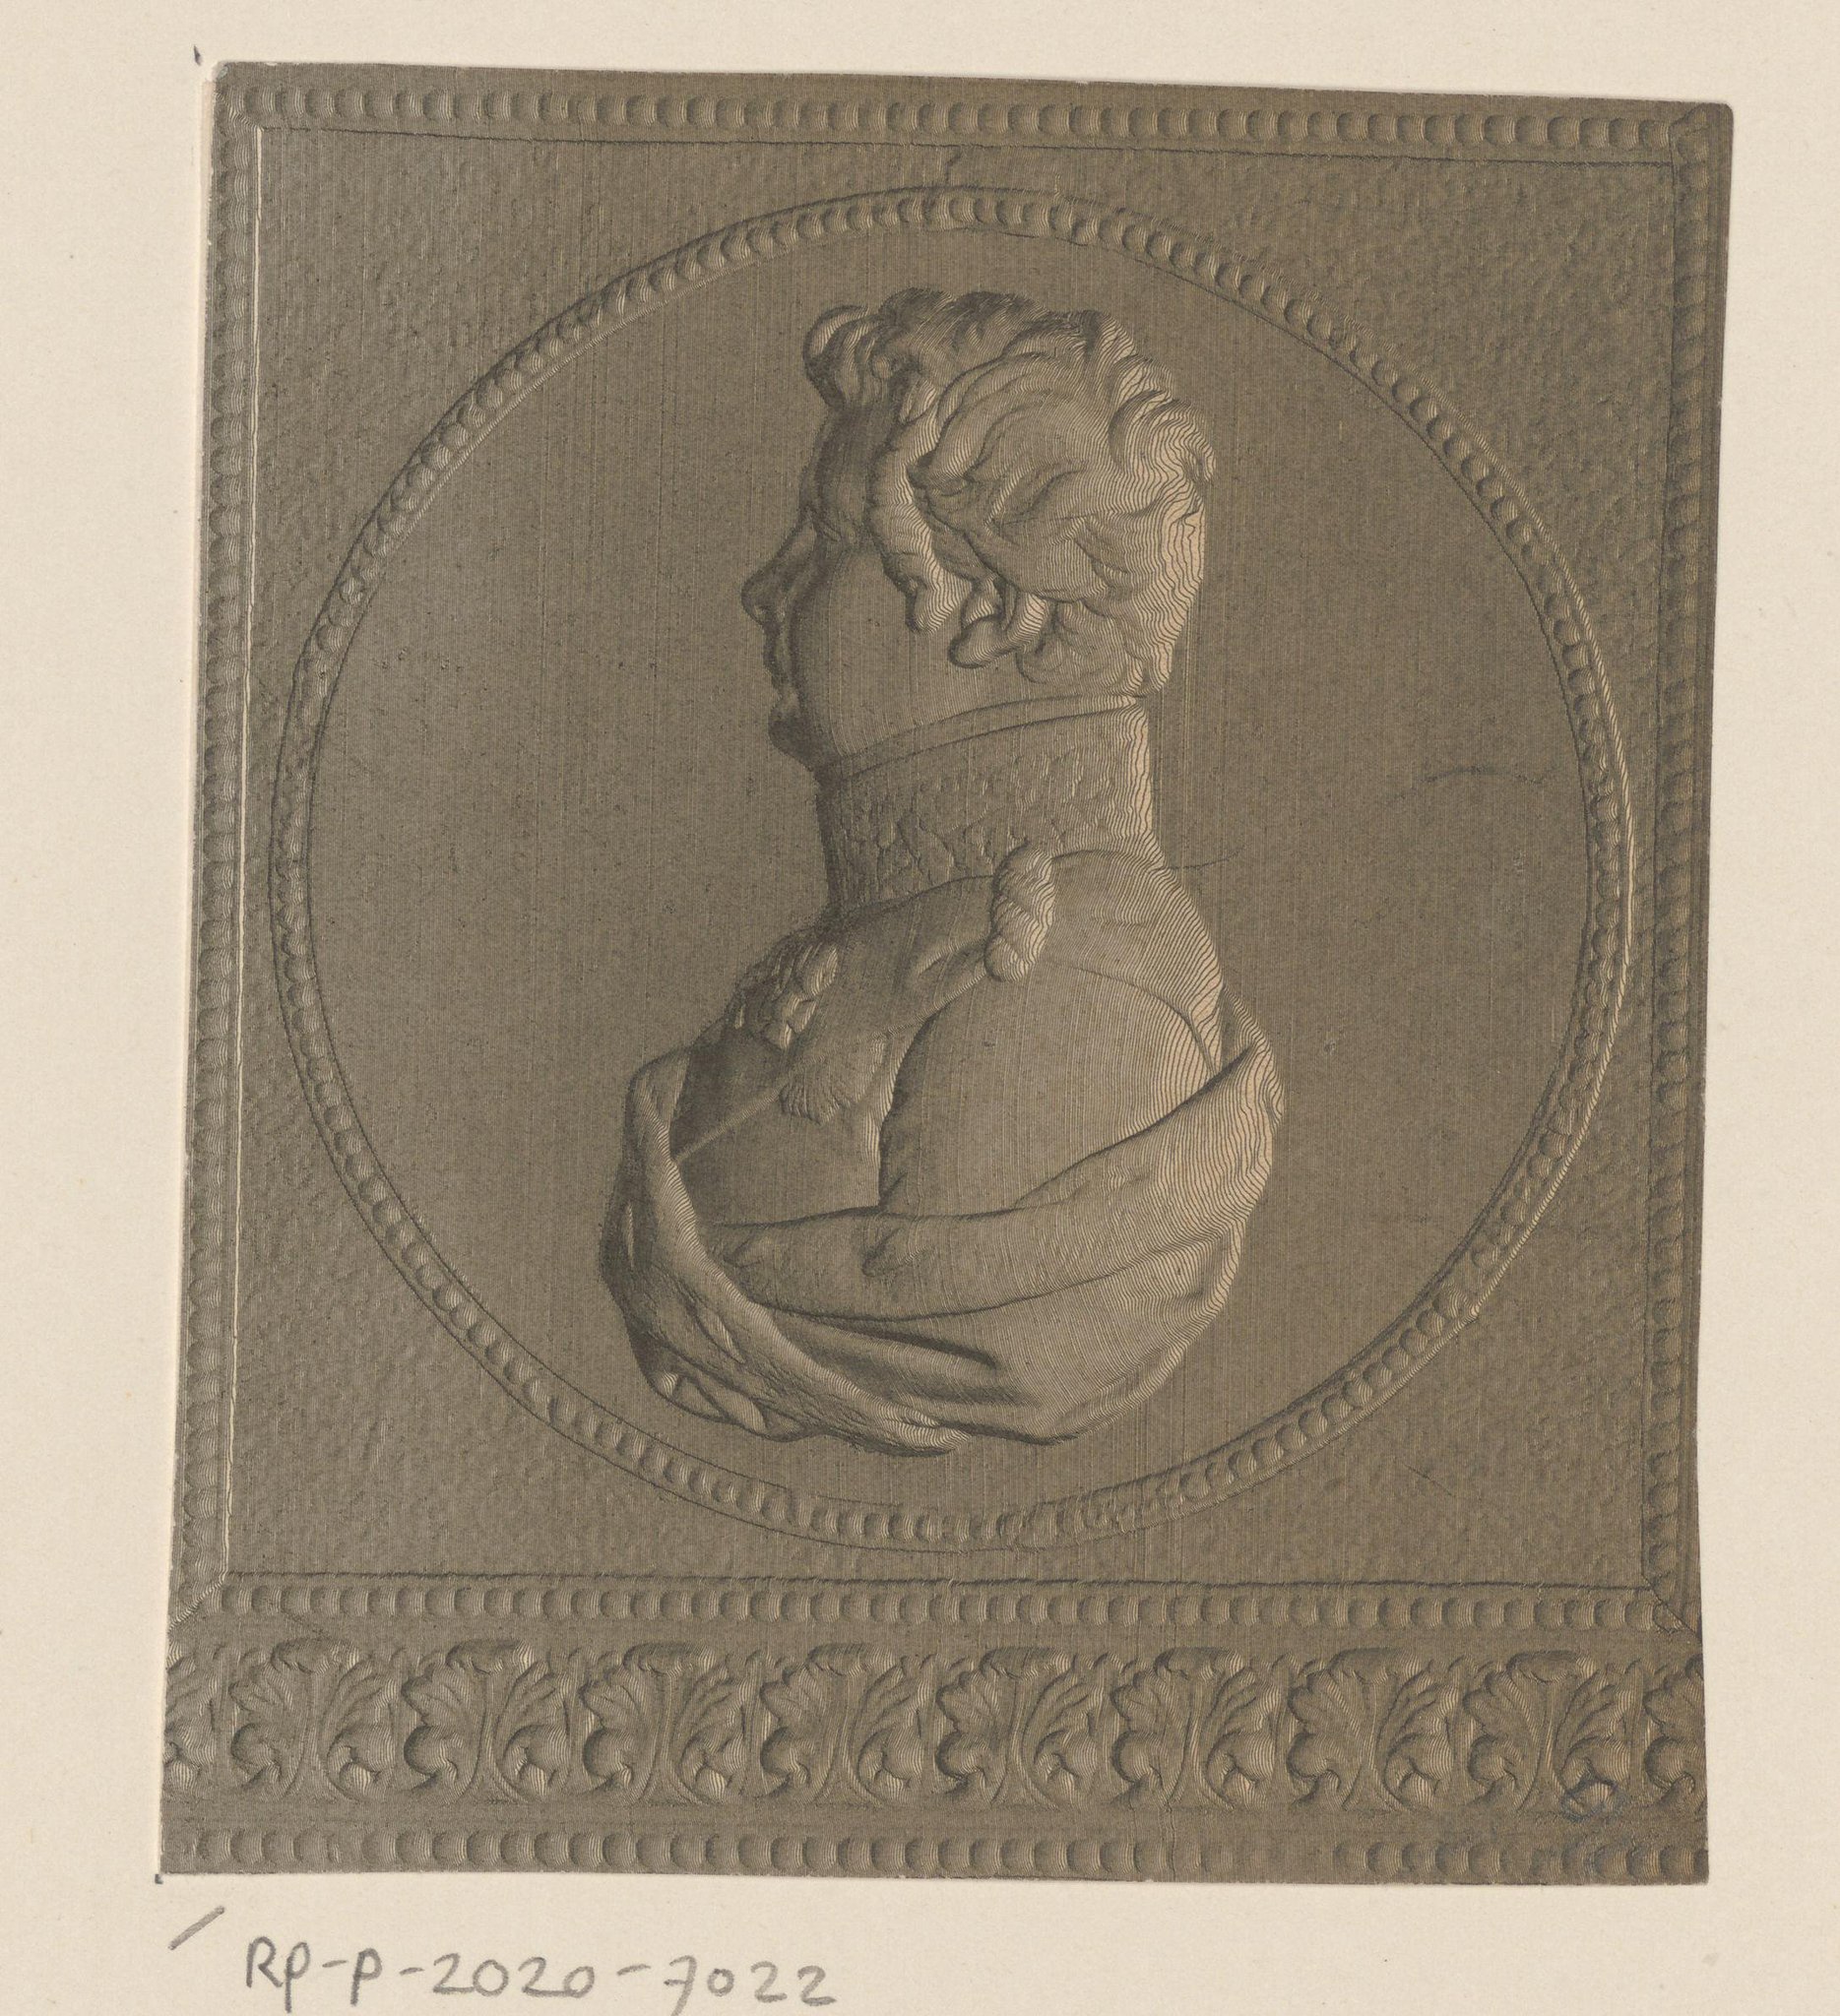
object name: print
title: Portret van Frederik Willem IV van Pruisen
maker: Anonymous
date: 1840-1899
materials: paper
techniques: relief engraving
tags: berlin, frederik willem iv (koning van pruisen), ornament ~ medallion, historical persons, king